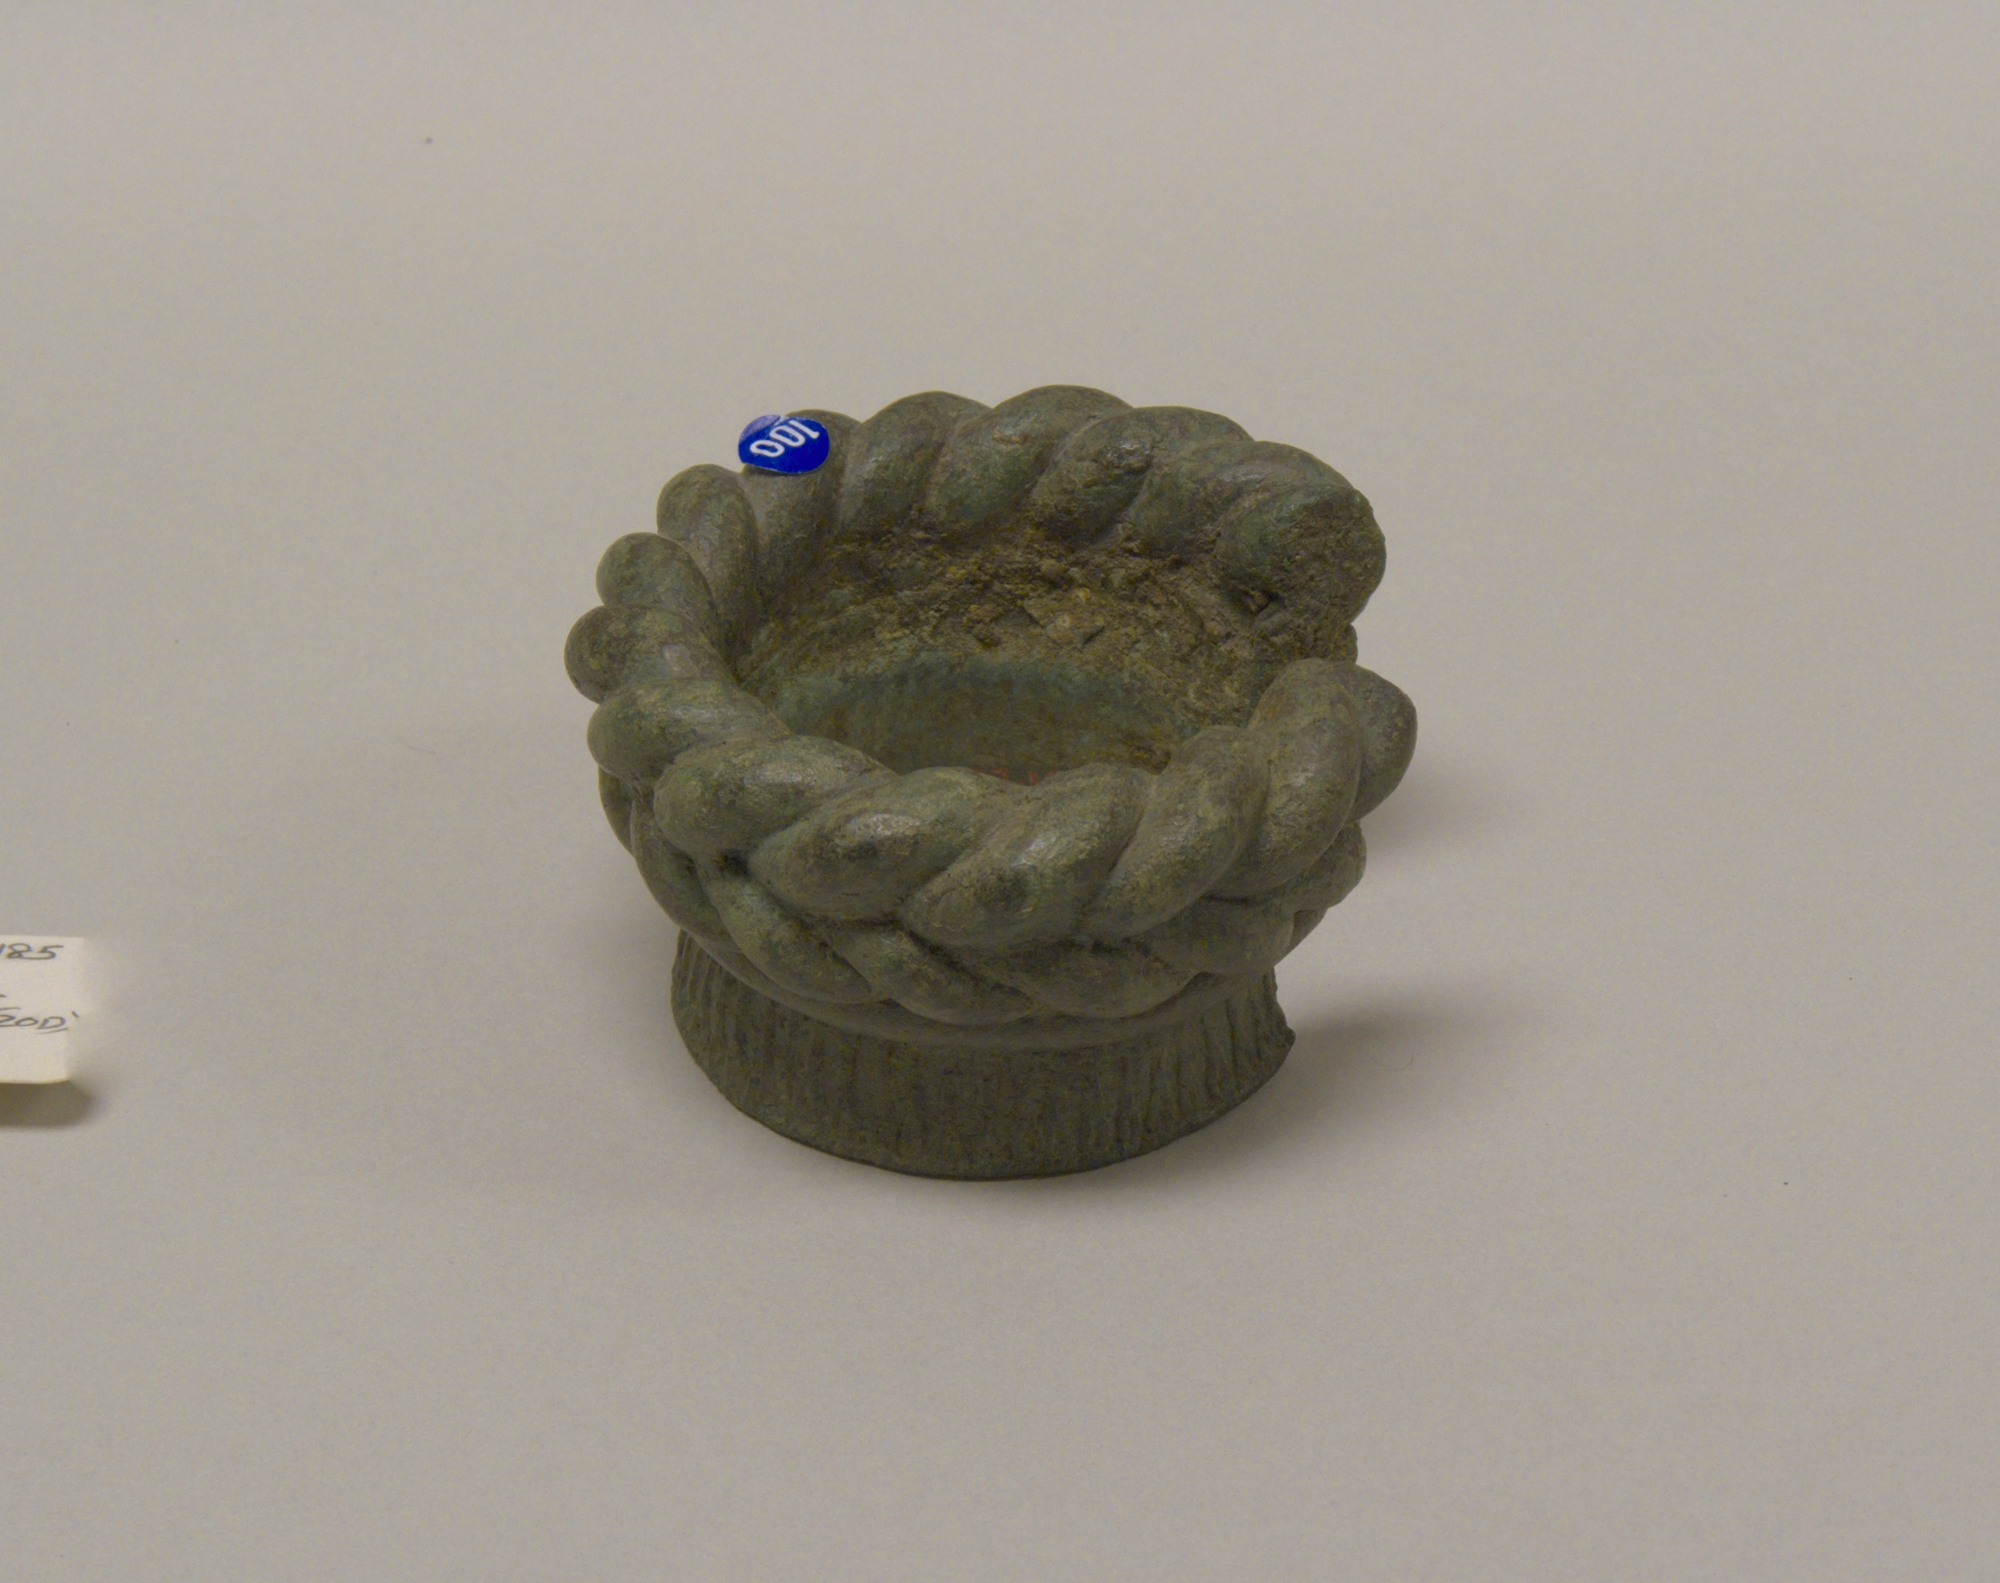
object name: one of a pair of bracelet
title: One from a Pair of Bracelets with Heavy Rope Braid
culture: thai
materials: bronze